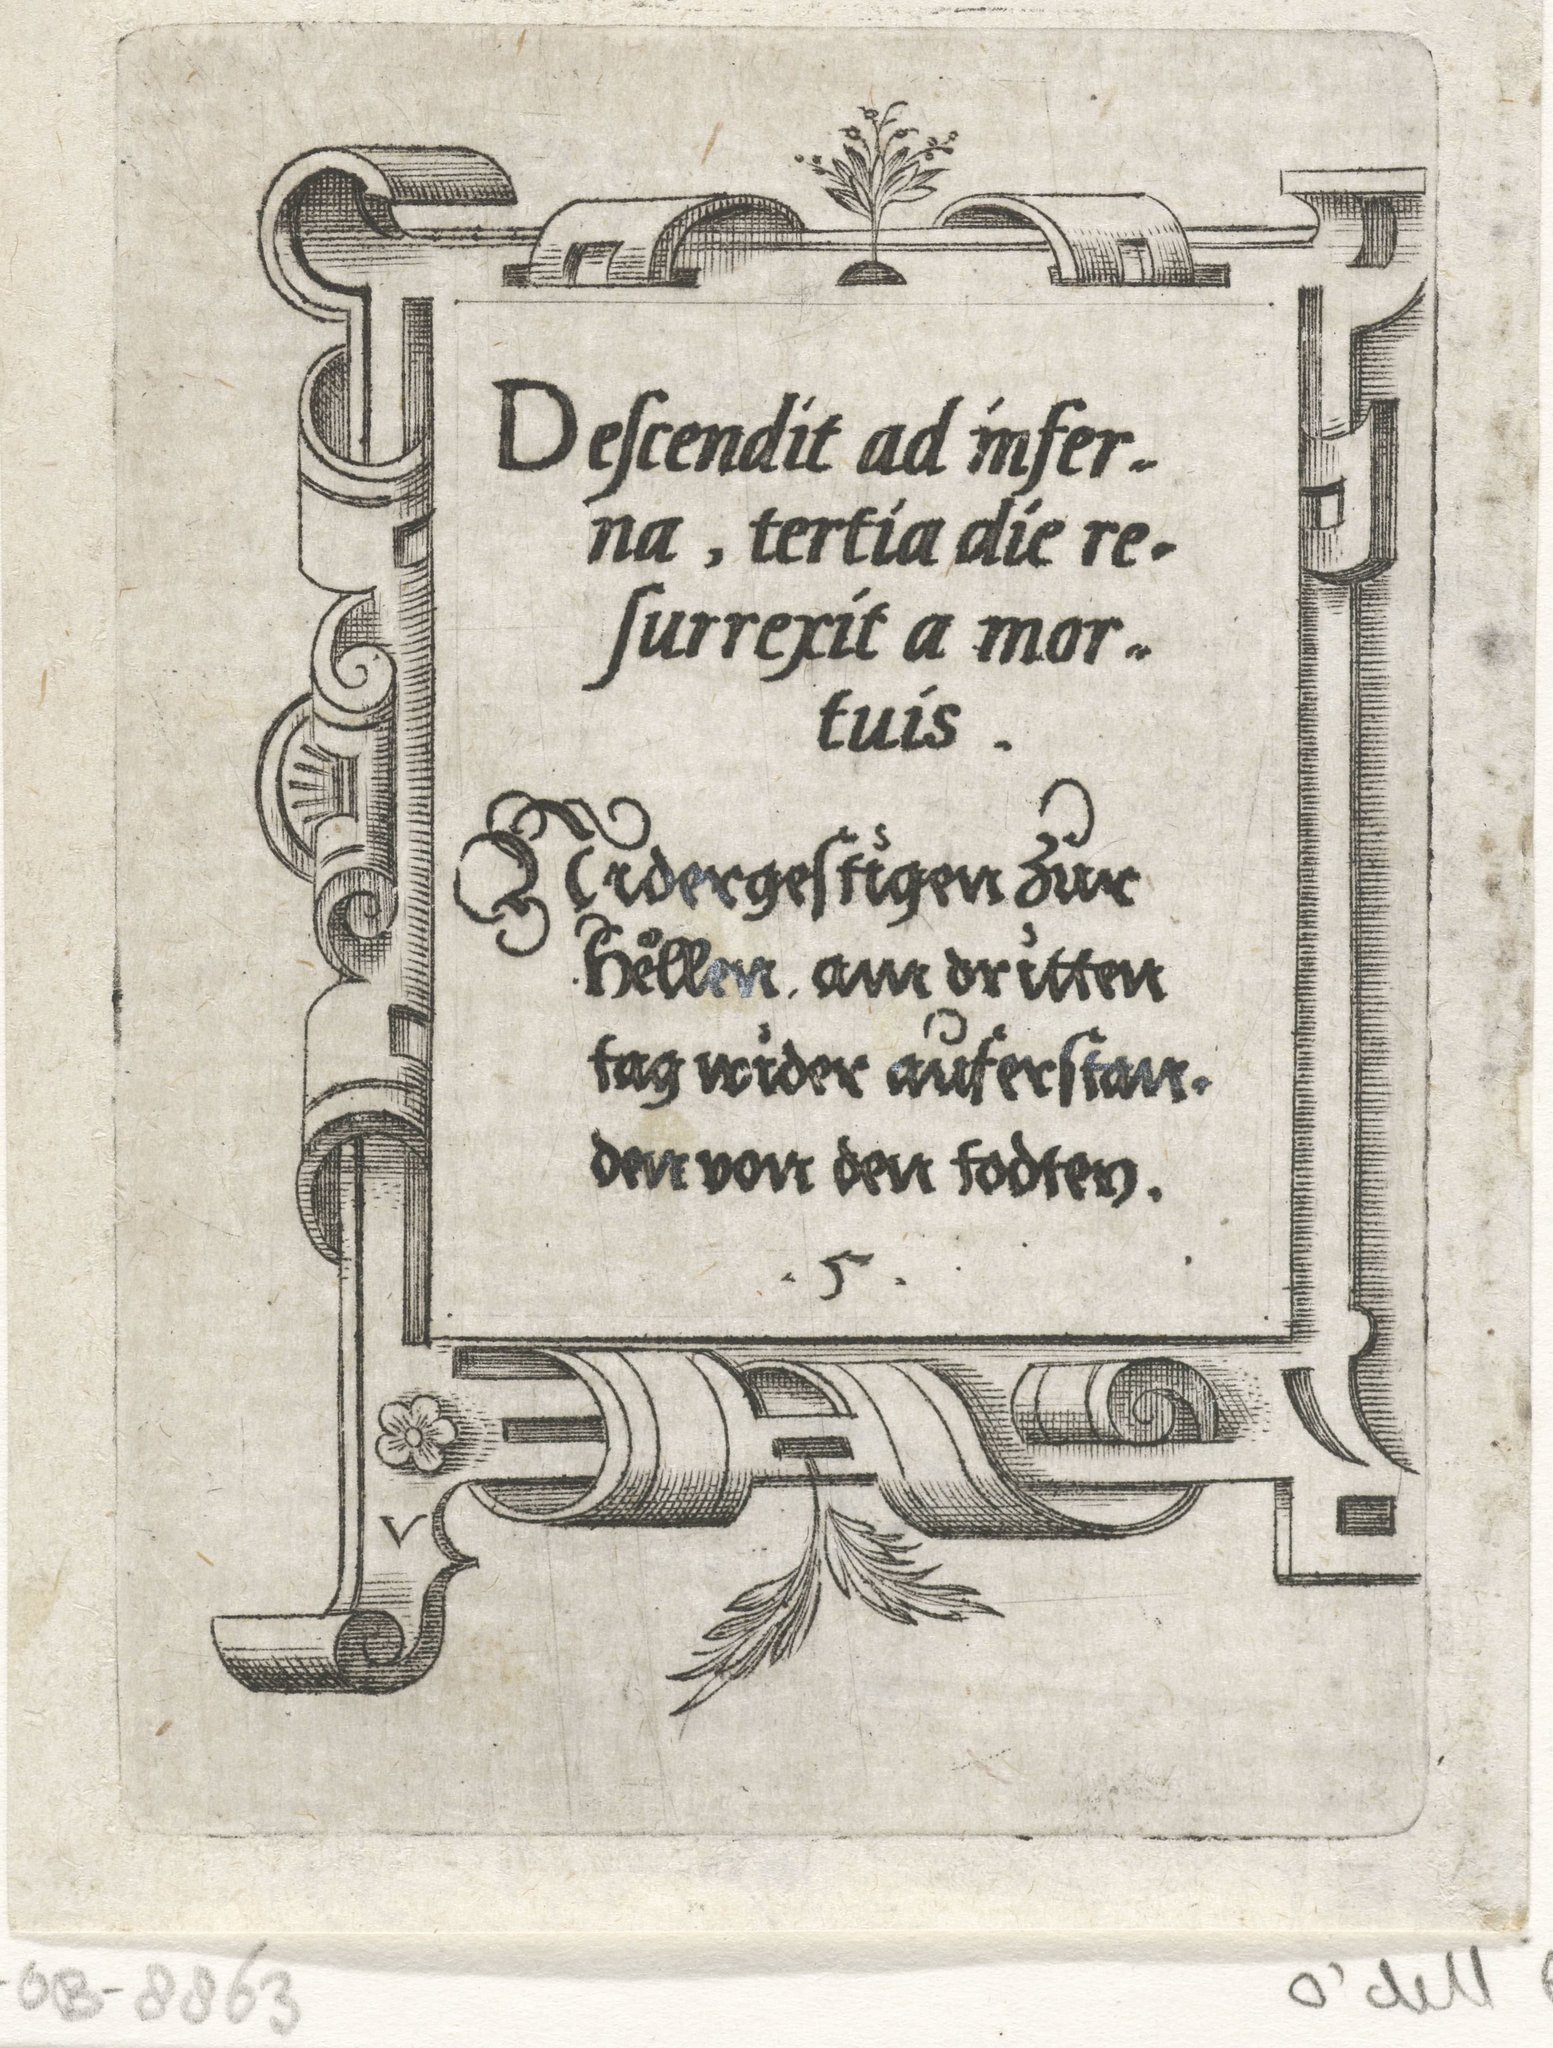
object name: print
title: Tekst: Descendit...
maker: virgilius solis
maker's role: draughtsman, print maker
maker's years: 1514-1562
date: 1524-1562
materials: paper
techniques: engraving